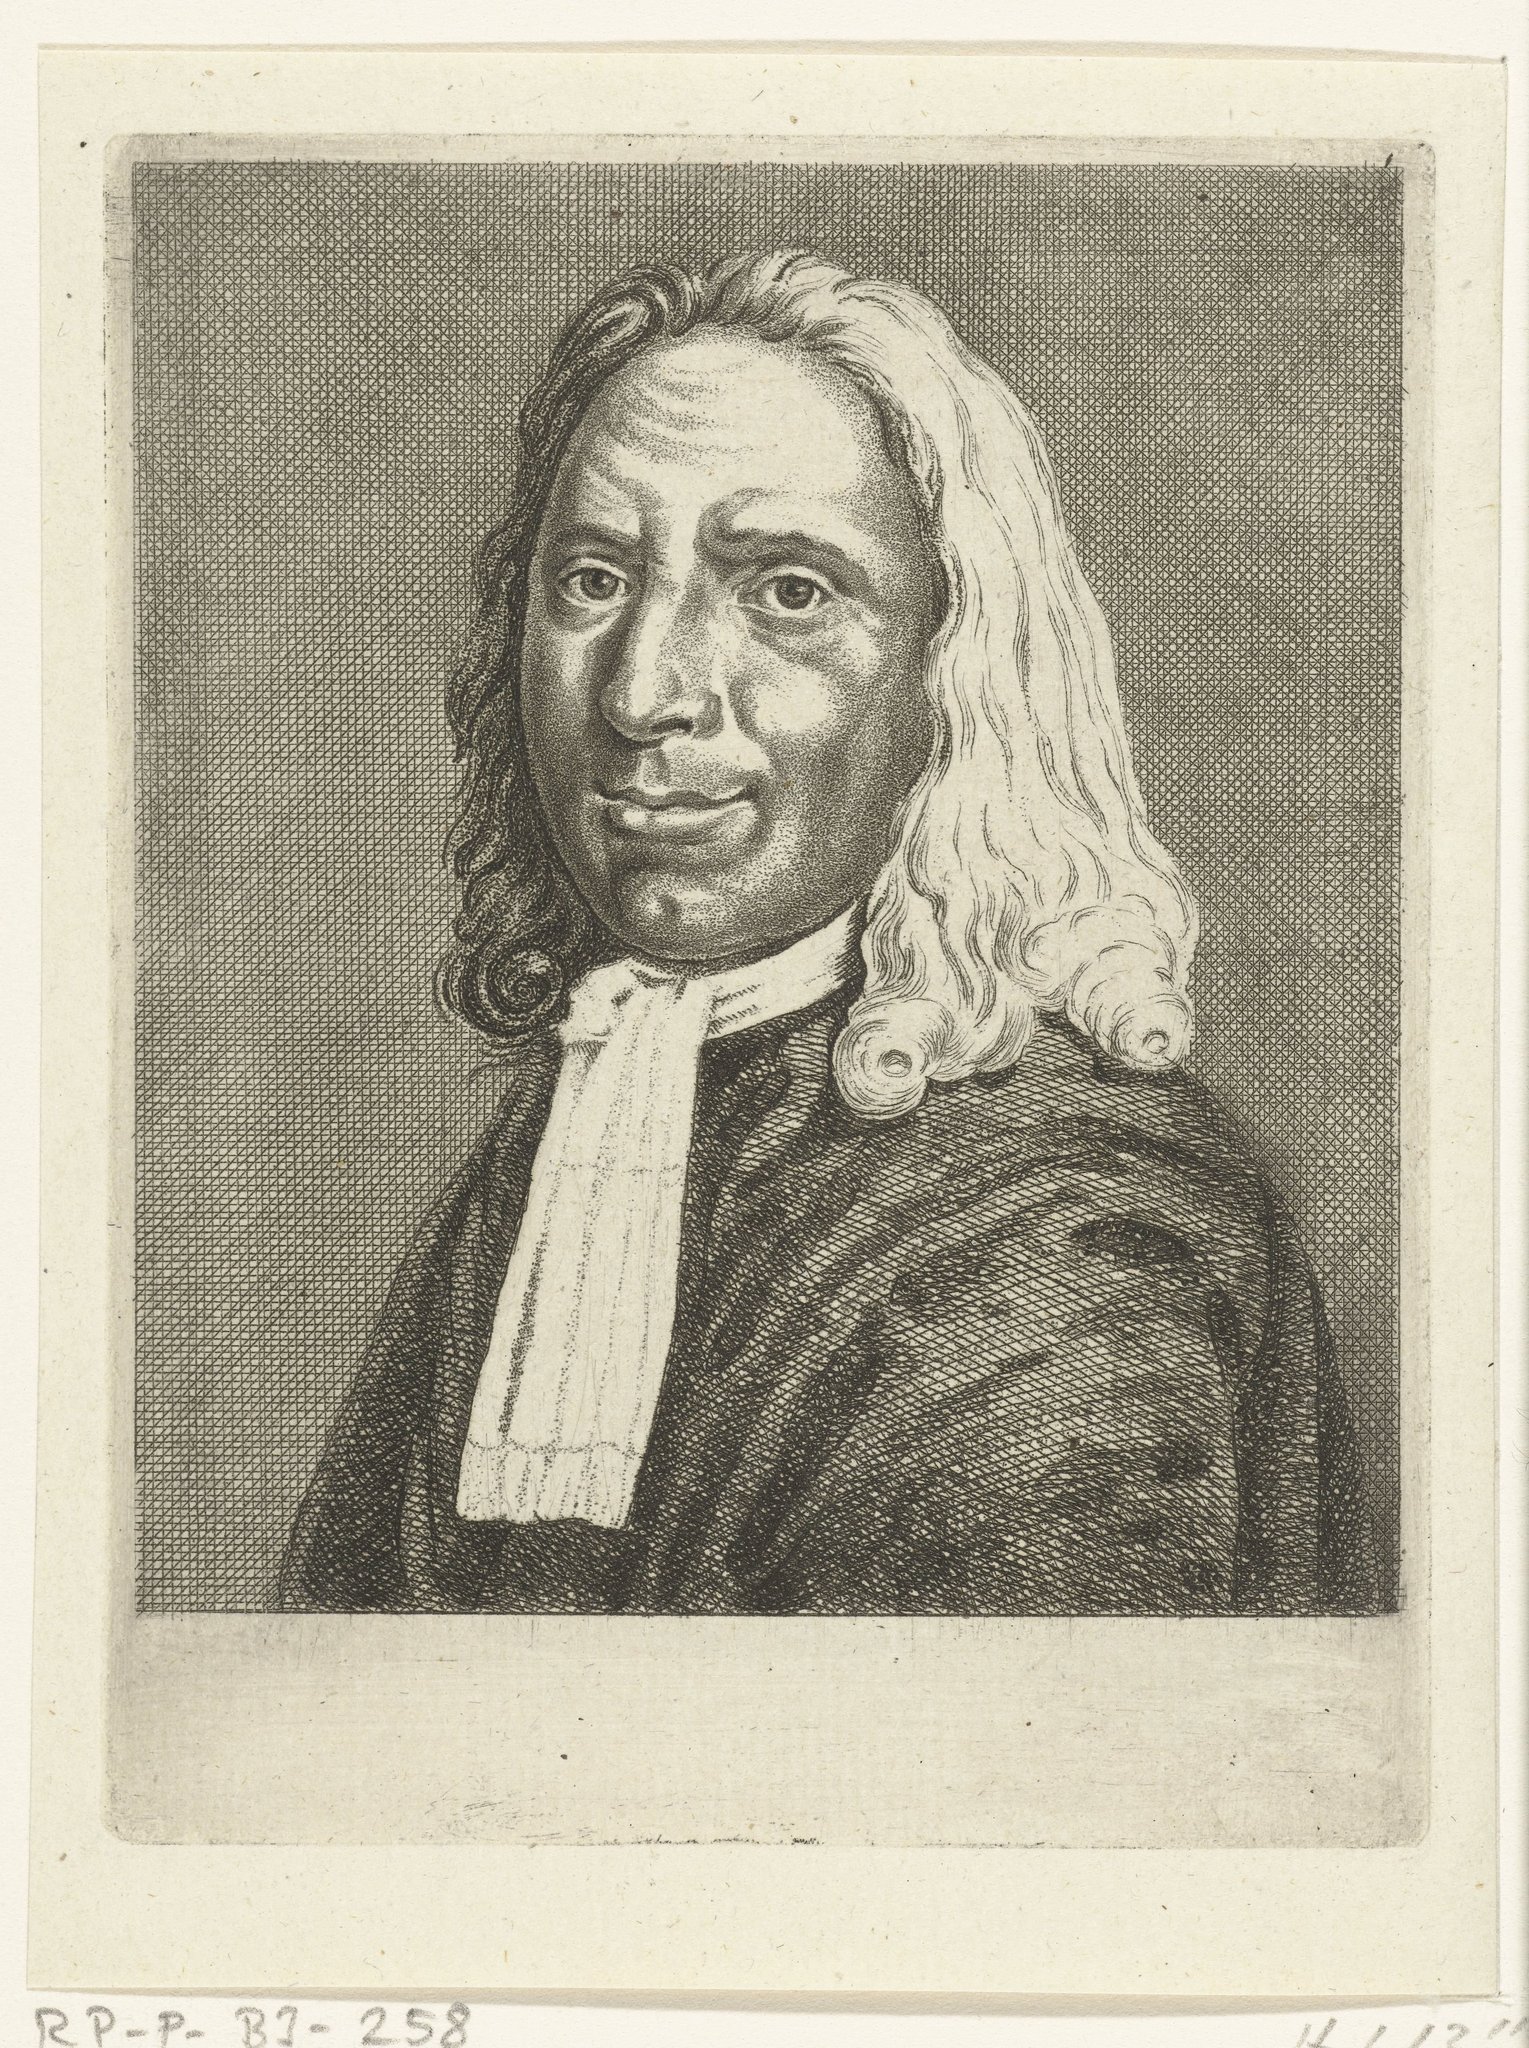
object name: print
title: Portret van Albert Cuyp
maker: ernst willem jan bagelaar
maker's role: draughtsman, print maker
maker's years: 1775-1837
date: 1798-1837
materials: paper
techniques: etching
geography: netherlands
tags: print maker, richard brakenburg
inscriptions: collector's mark: Lugt 2228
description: Volgens H&L portret van A. Cuyp, echter wellicht portret van R. Brakenburg